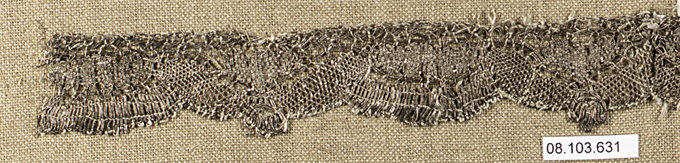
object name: piece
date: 1701-1800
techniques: lace